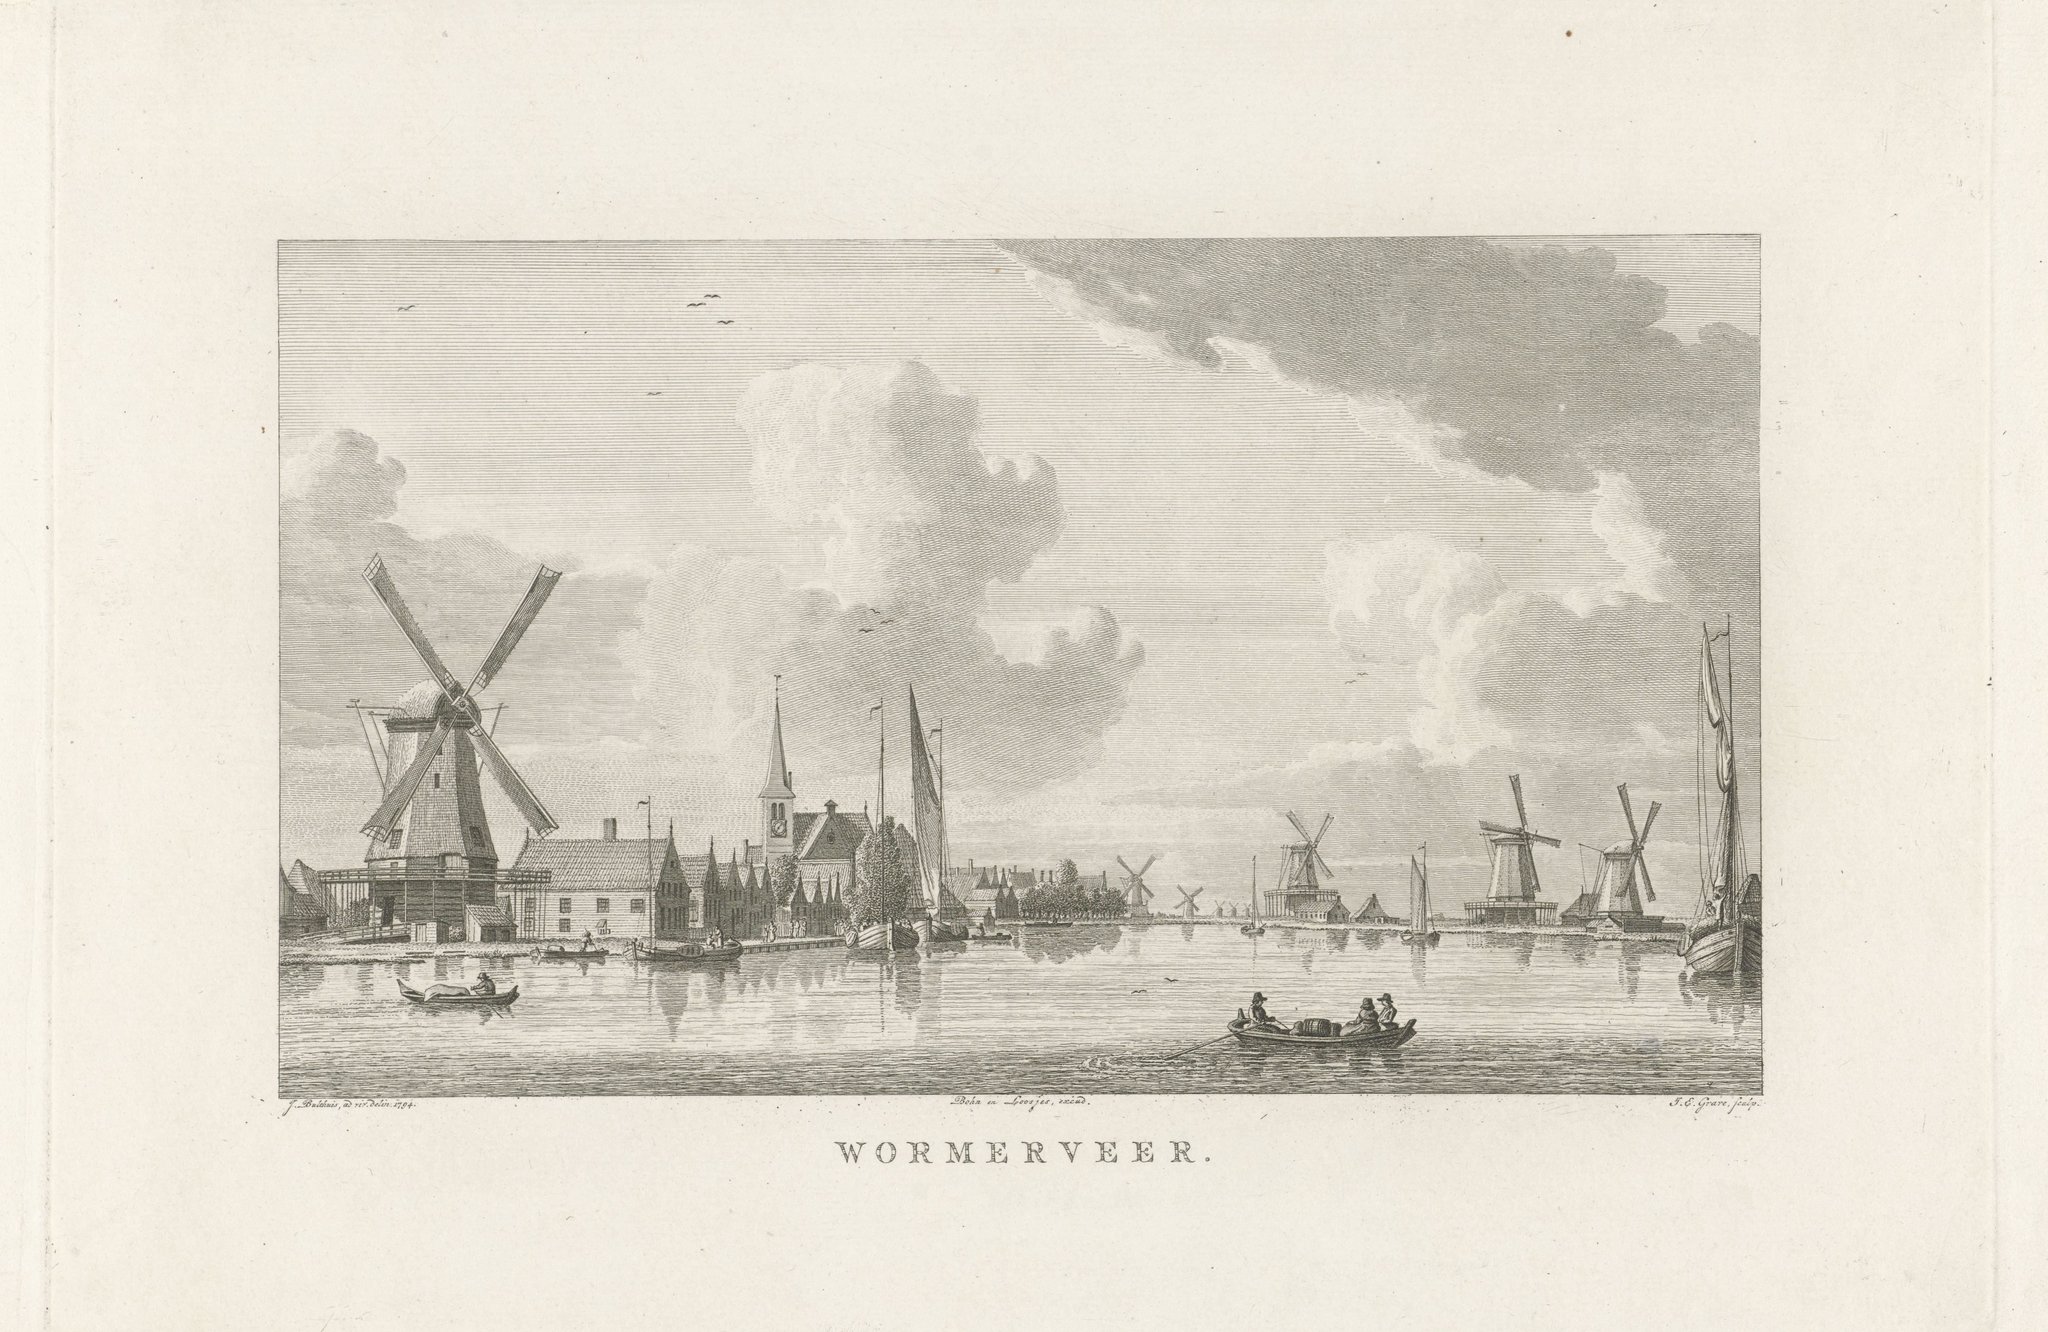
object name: print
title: Gezicht op Wormerveer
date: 1794-1805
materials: paper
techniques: engraving, etching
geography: amsterdam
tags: windmill in landscape, river (+ landscape with figures, staffage)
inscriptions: collector's mark: Lugt 2228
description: Het dorp Wormerveer. Op de voorgrond de rivier de Zaan. Op de achtergrond de kerktoren en windmolens.